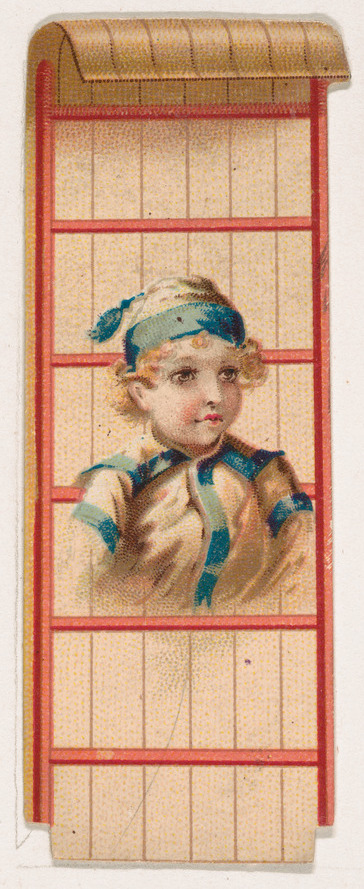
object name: print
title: Toboggan, from the Novelties series (N228, Type 3) issued by Kinney Bros.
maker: kinney brothers tobacco company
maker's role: publisher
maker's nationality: american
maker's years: 1869-2011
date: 1889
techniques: color lithograph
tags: girls